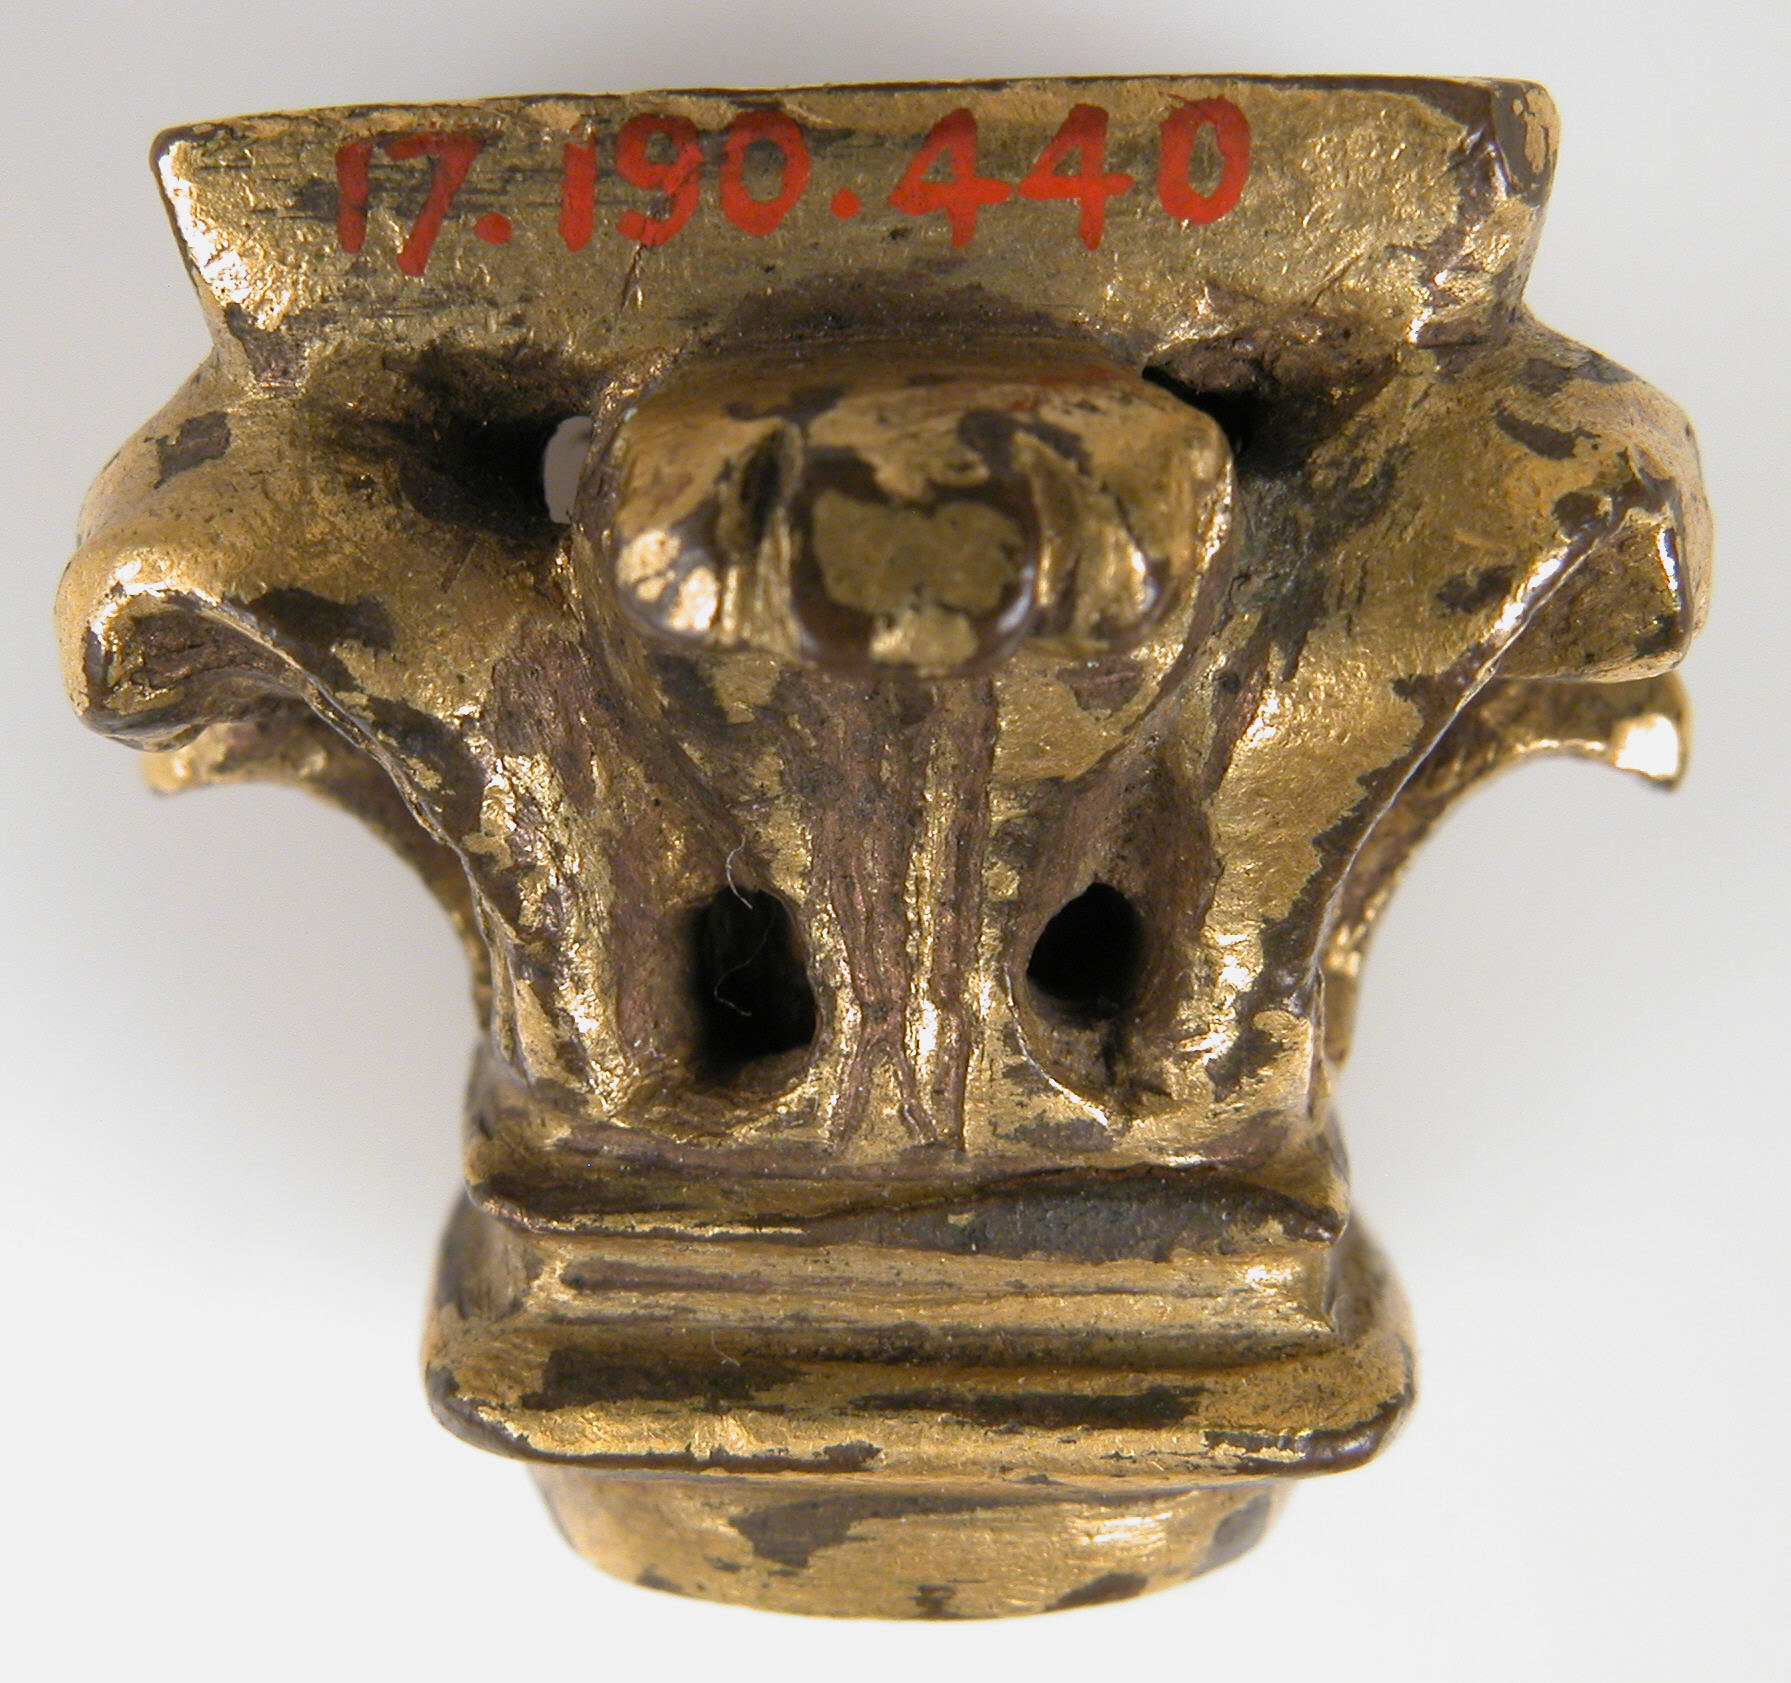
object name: capital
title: Capital from a Reliquary Shrine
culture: german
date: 1175-1200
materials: copper alloy, gilt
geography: germany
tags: reliquaries